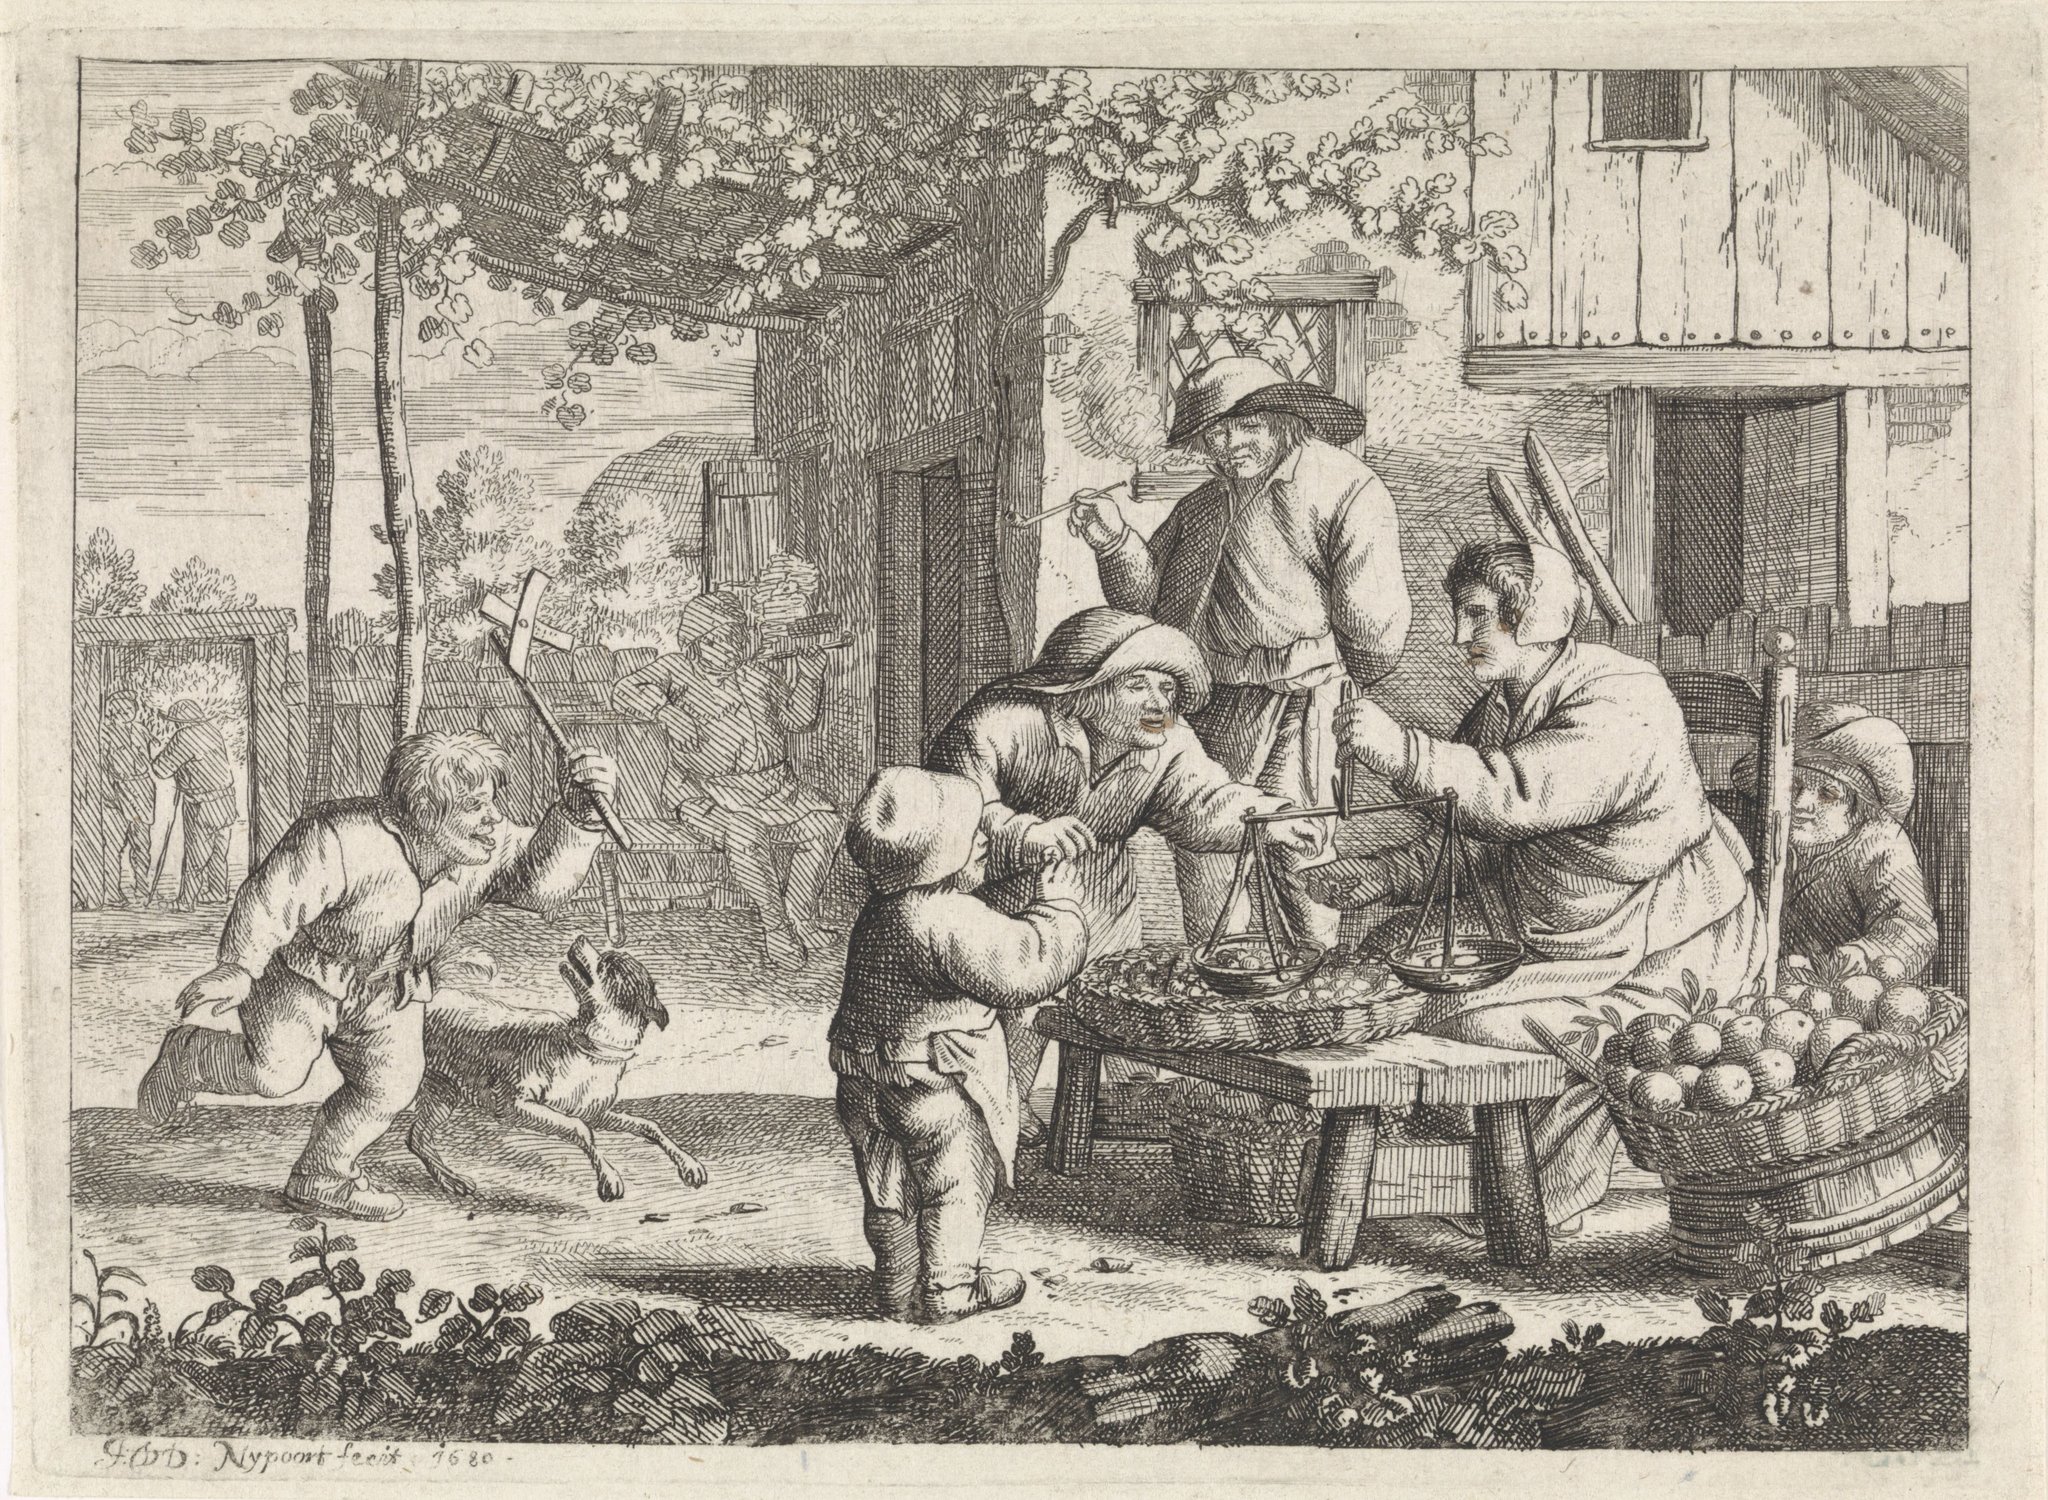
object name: print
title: Appelverkoopster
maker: justus van den nijpoort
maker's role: draughtsman, print maker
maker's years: 1625-1692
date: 1680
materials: paper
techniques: engraving, etching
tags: fruits: apple, scales, pipe ~ tobacco, buying and selling, dog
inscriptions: collector's mark: Lugt 2165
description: Een verkoopster van appels, die in de mand naast haar staan, weegt de koopwaren, terwijl een man haar betaald. Achter haar stoel probeert een jongen een appel te stelen. Links komt een jongen met een hond aanrennen, terwijl hij een windmolentje in de hand houdt. Een man met een pijp kijkt naar de verkoop.